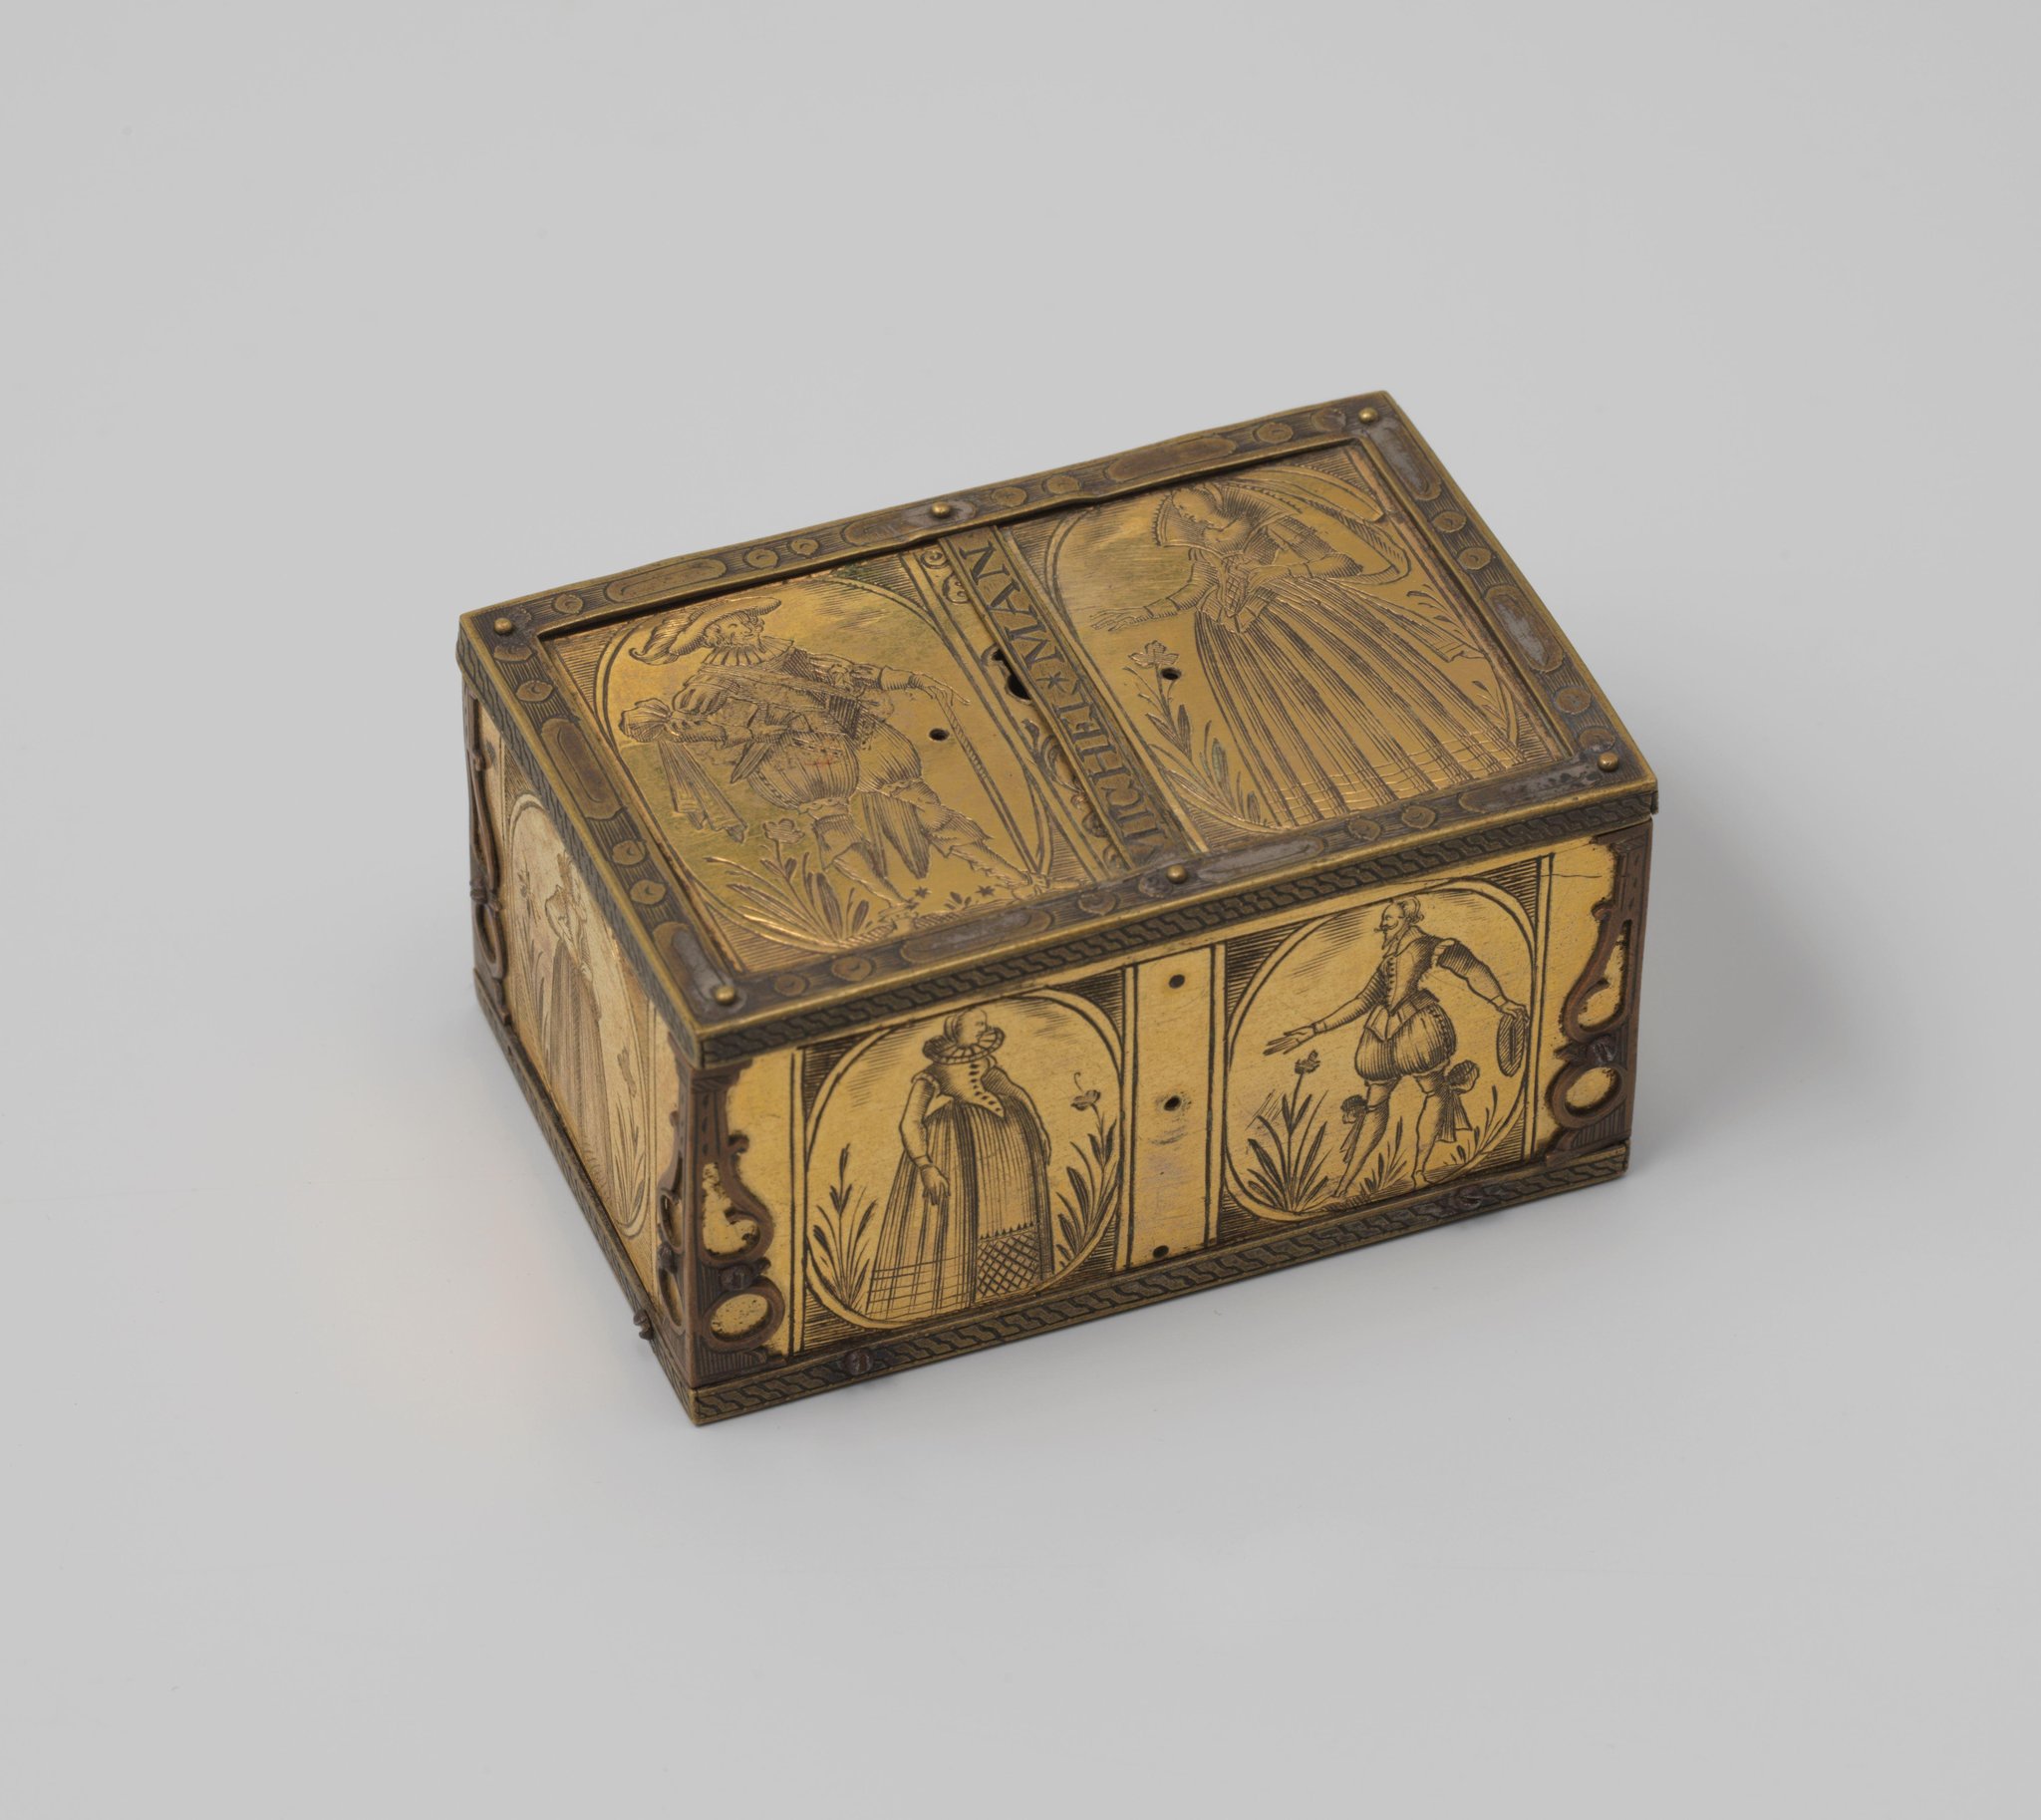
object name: knottedoos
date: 1600-1625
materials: silver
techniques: gilding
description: Knottedoos (?) van zilver (?) gedeeltelijk verguld. In de vorm van een geldkist en gegraveerd met mannen- en vrouwenfiguren in medaillons.